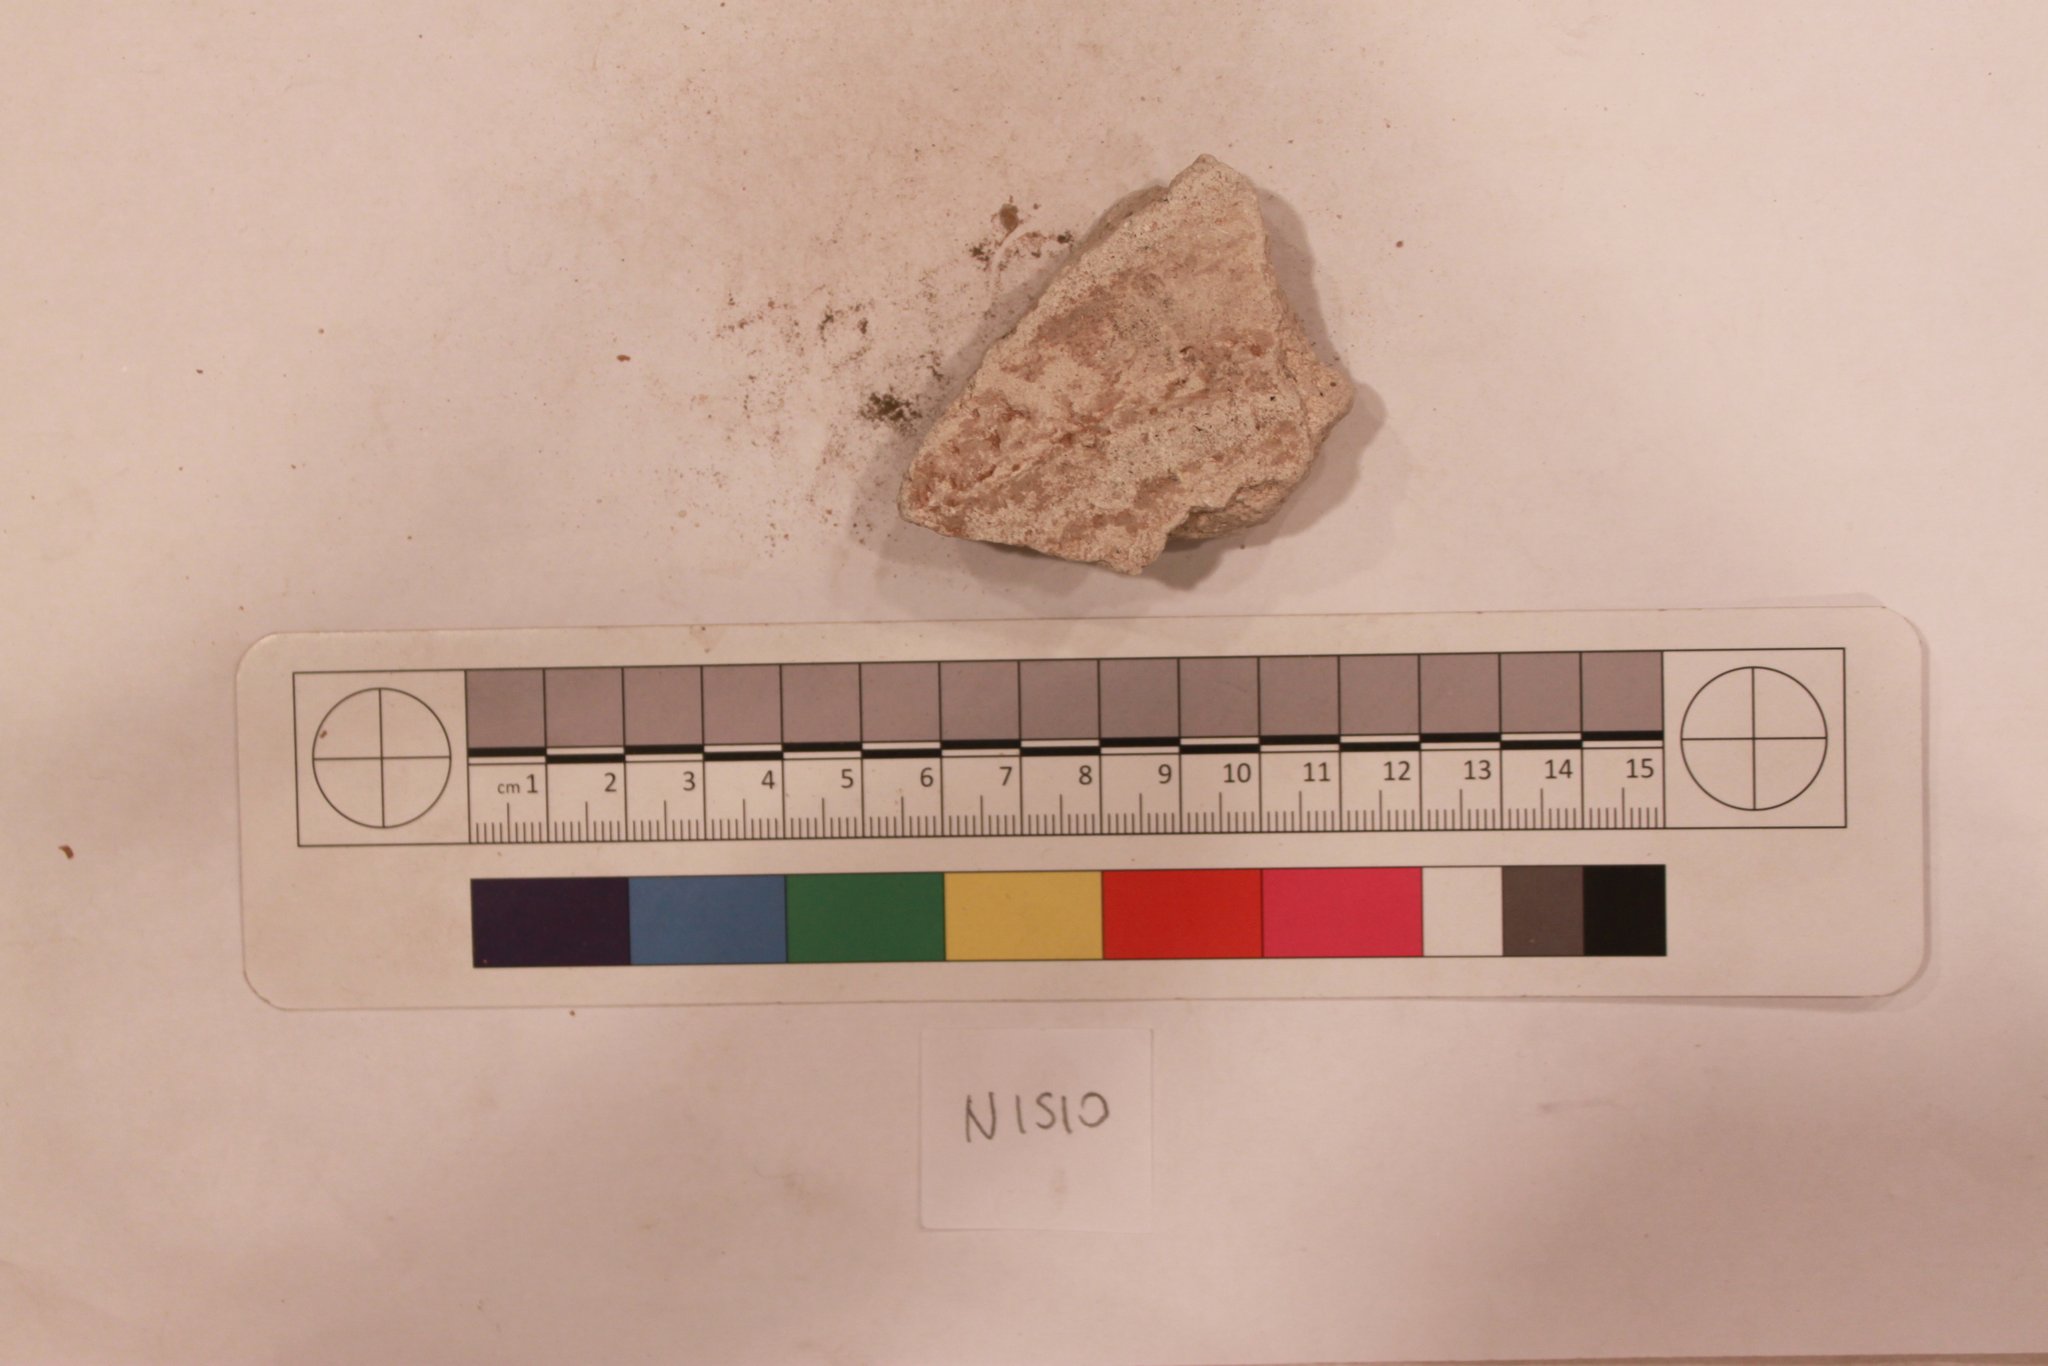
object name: fragment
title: Stucco Fragment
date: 701-1200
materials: plaster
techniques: carving, painting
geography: iran